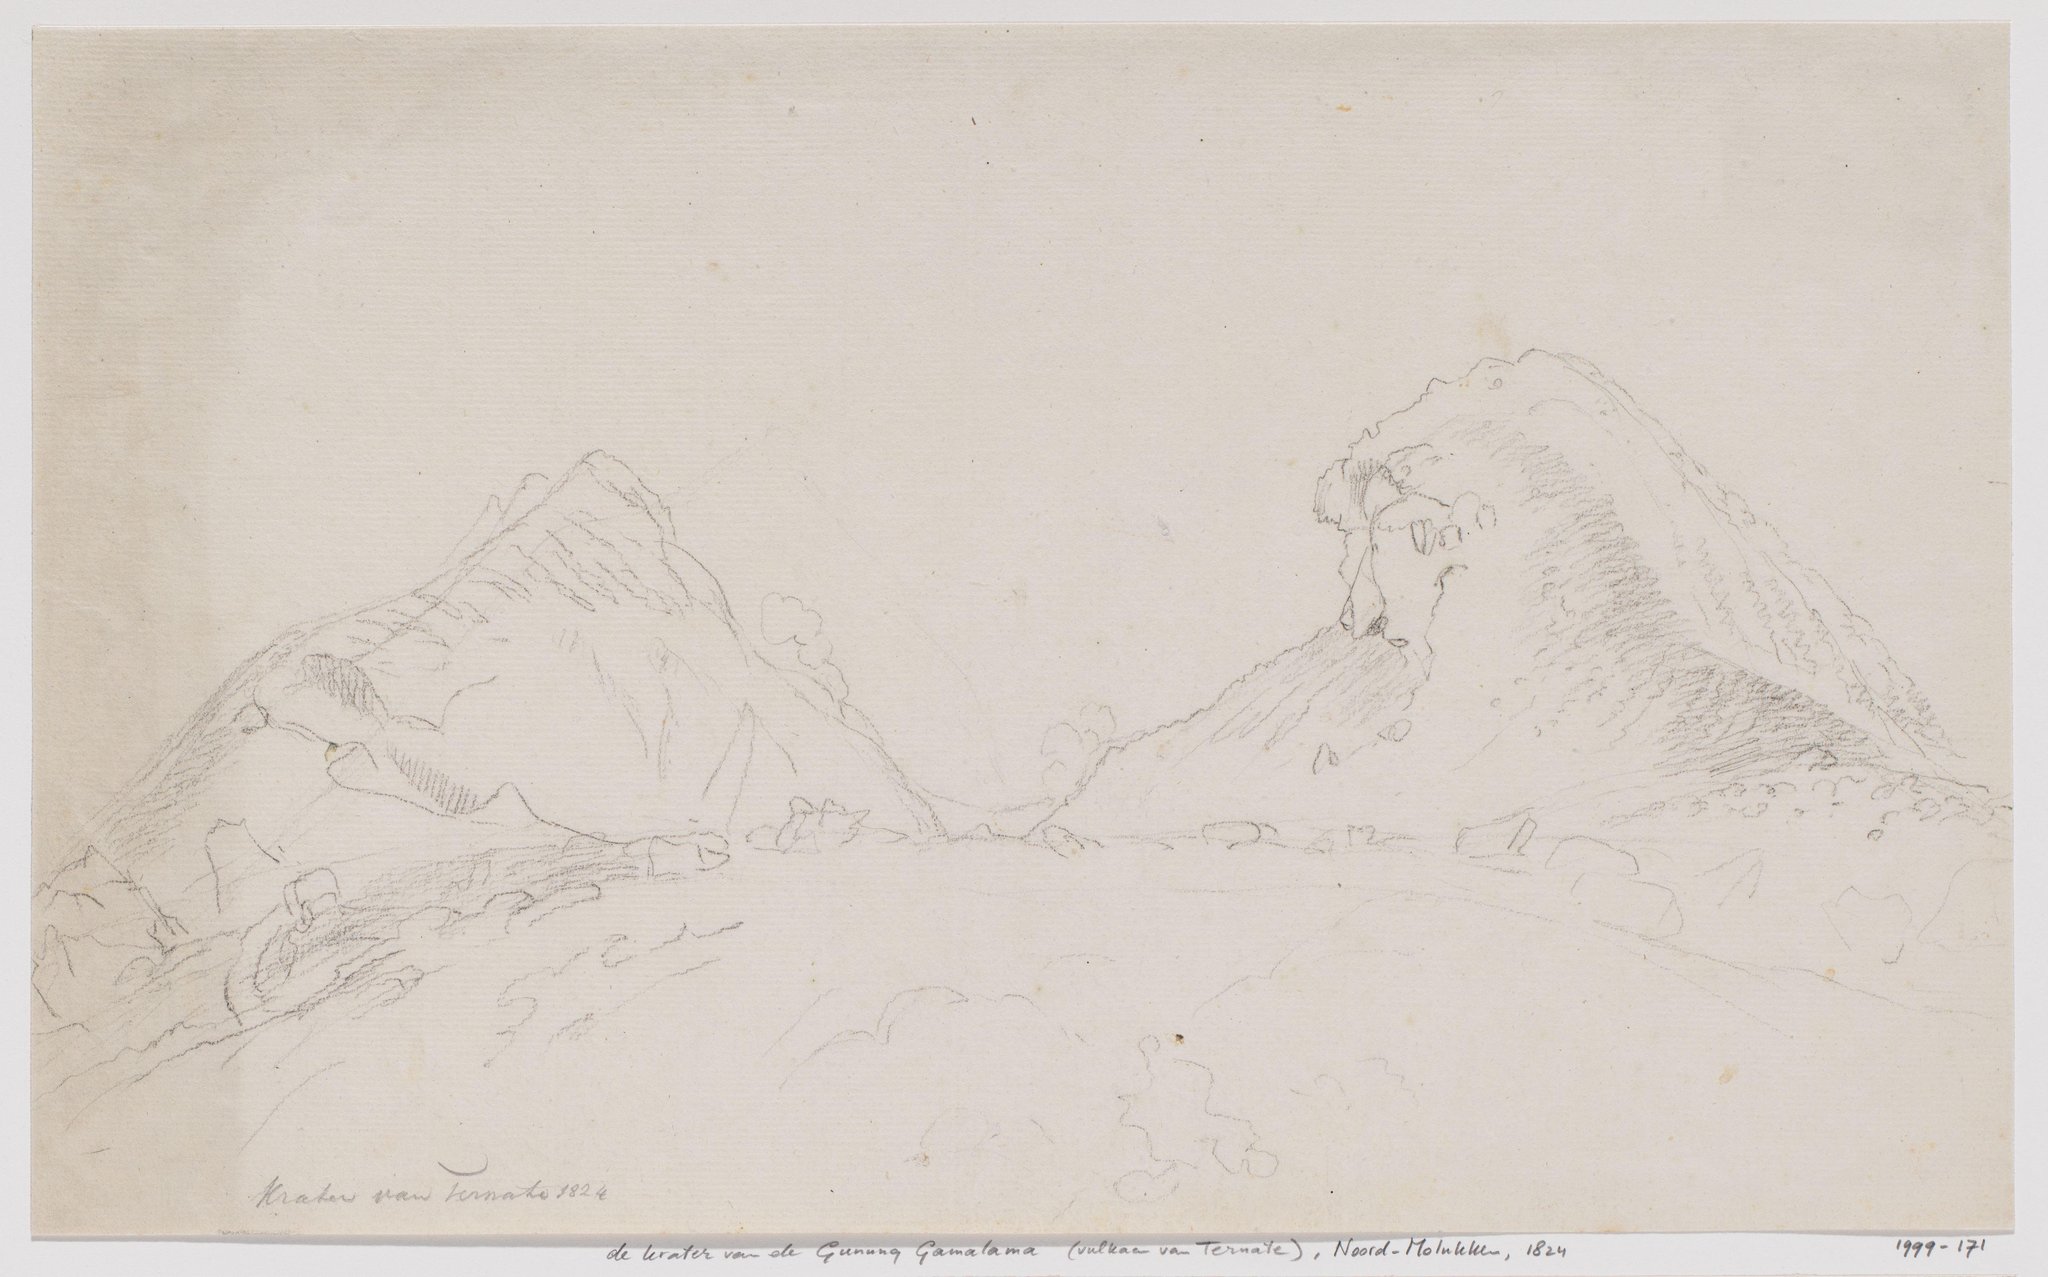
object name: drawing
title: Gezicht op de krater van de Gunung Gamalama, Noord-Molukken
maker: adrianus johannes bik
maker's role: draughtsman, print maker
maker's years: 1790-1872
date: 1824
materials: chalk, paper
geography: north moluccas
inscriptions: annotation: ‘krater van Ternate’, date: ‘1824’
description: artikel over deze collectie in Bulletin van het Rijksmuseum 49 [2001], nr. 4, pp.343 e.v